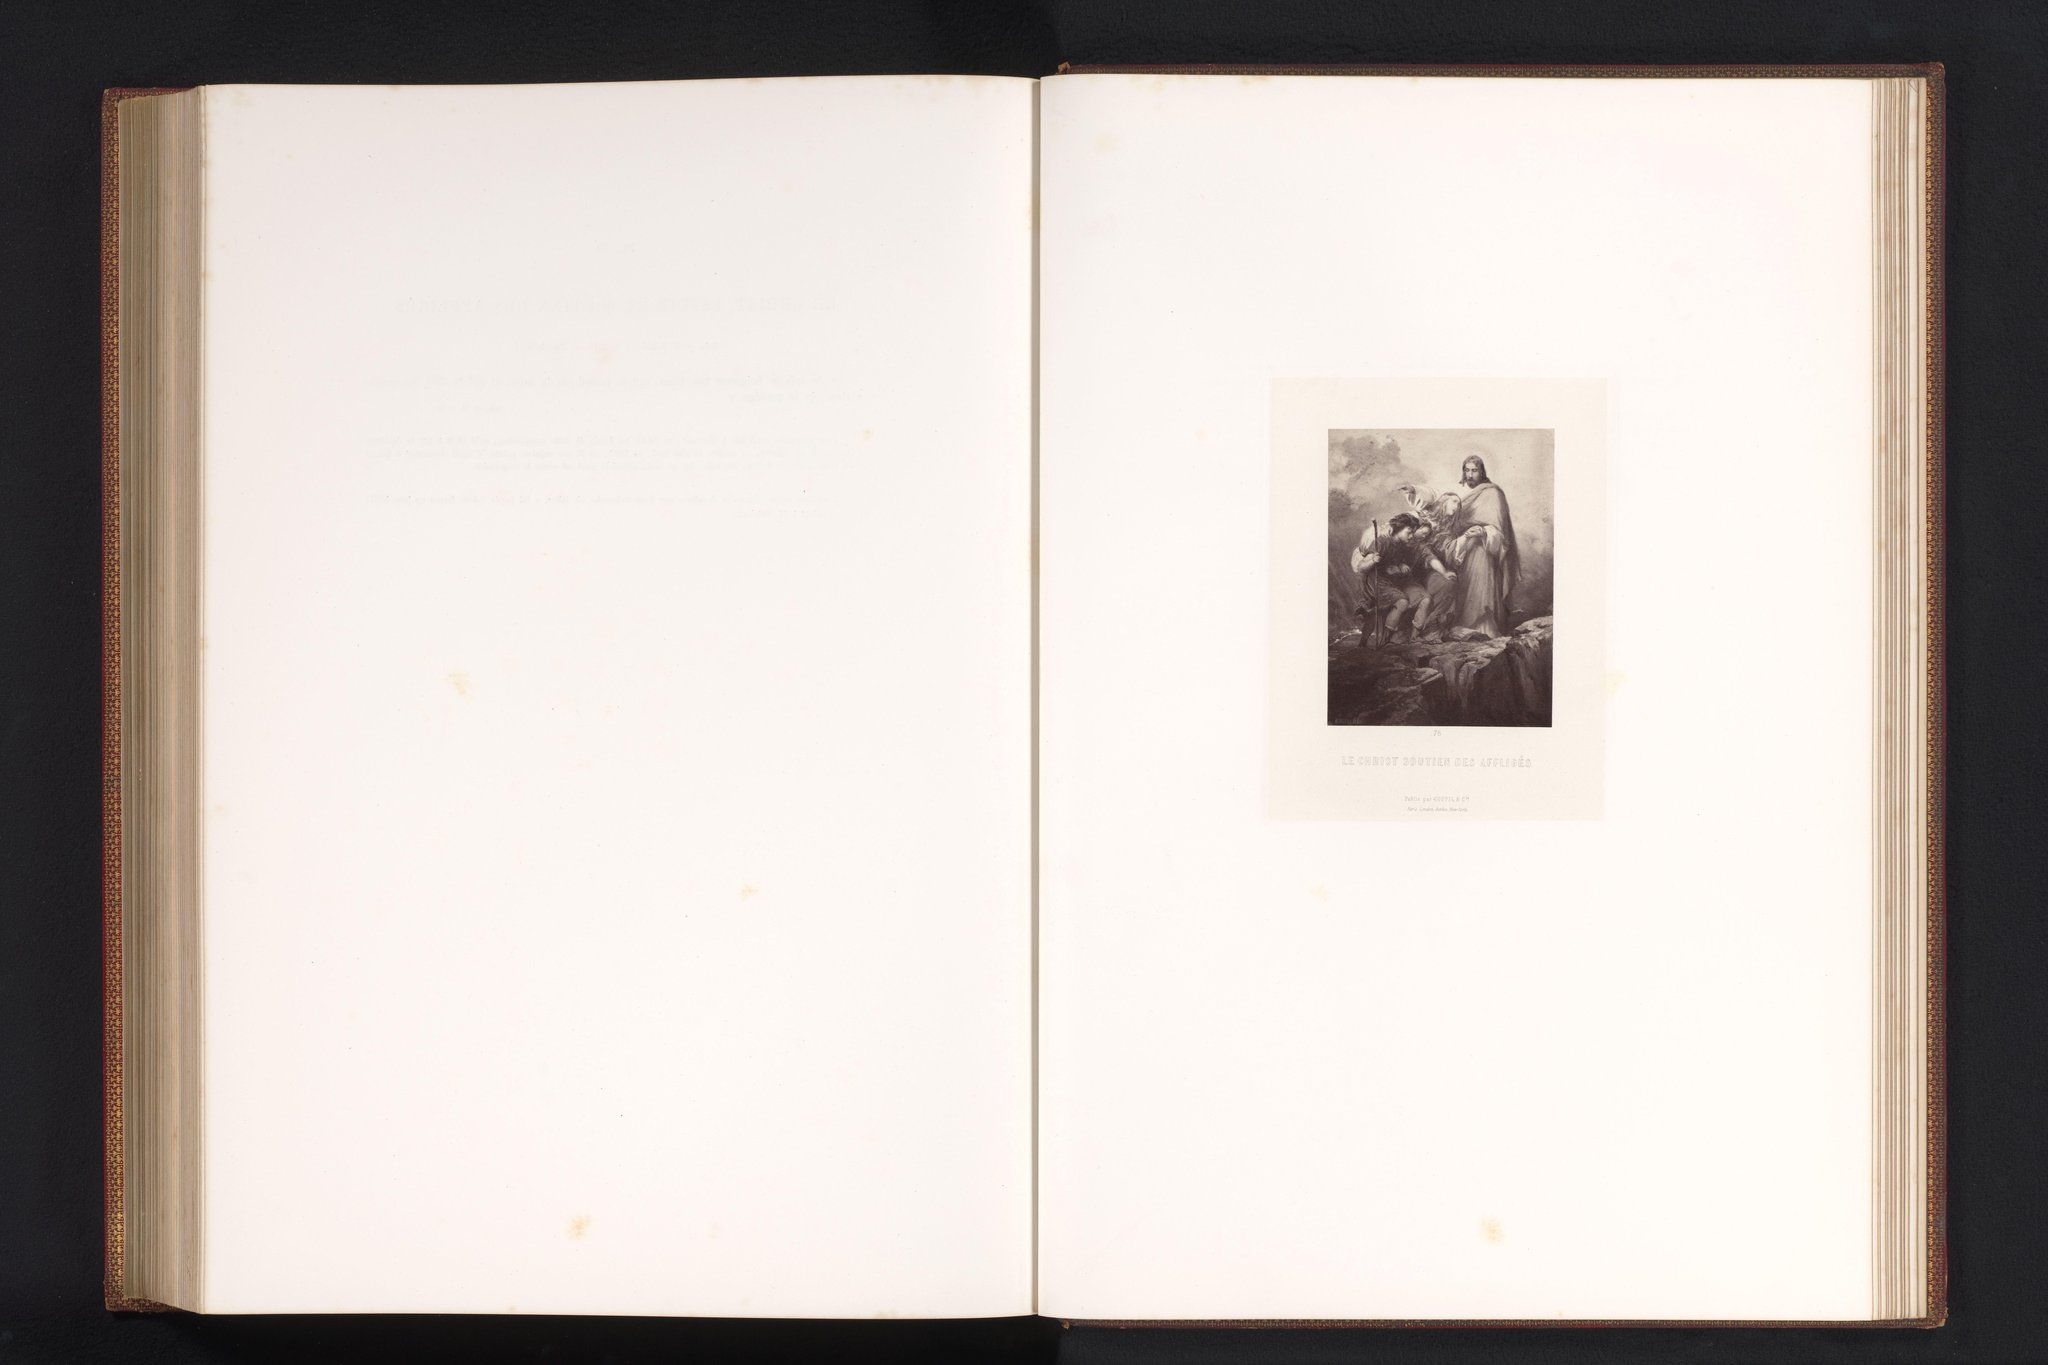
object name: reproduction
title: Le Christ, espoir et soutien des affligés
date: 1853-1858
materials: paper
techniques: albumen print, engraving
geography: paris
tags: adult christ together with others (non-narrative representations)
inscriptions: check stamp: ‘Goupil & Cie’